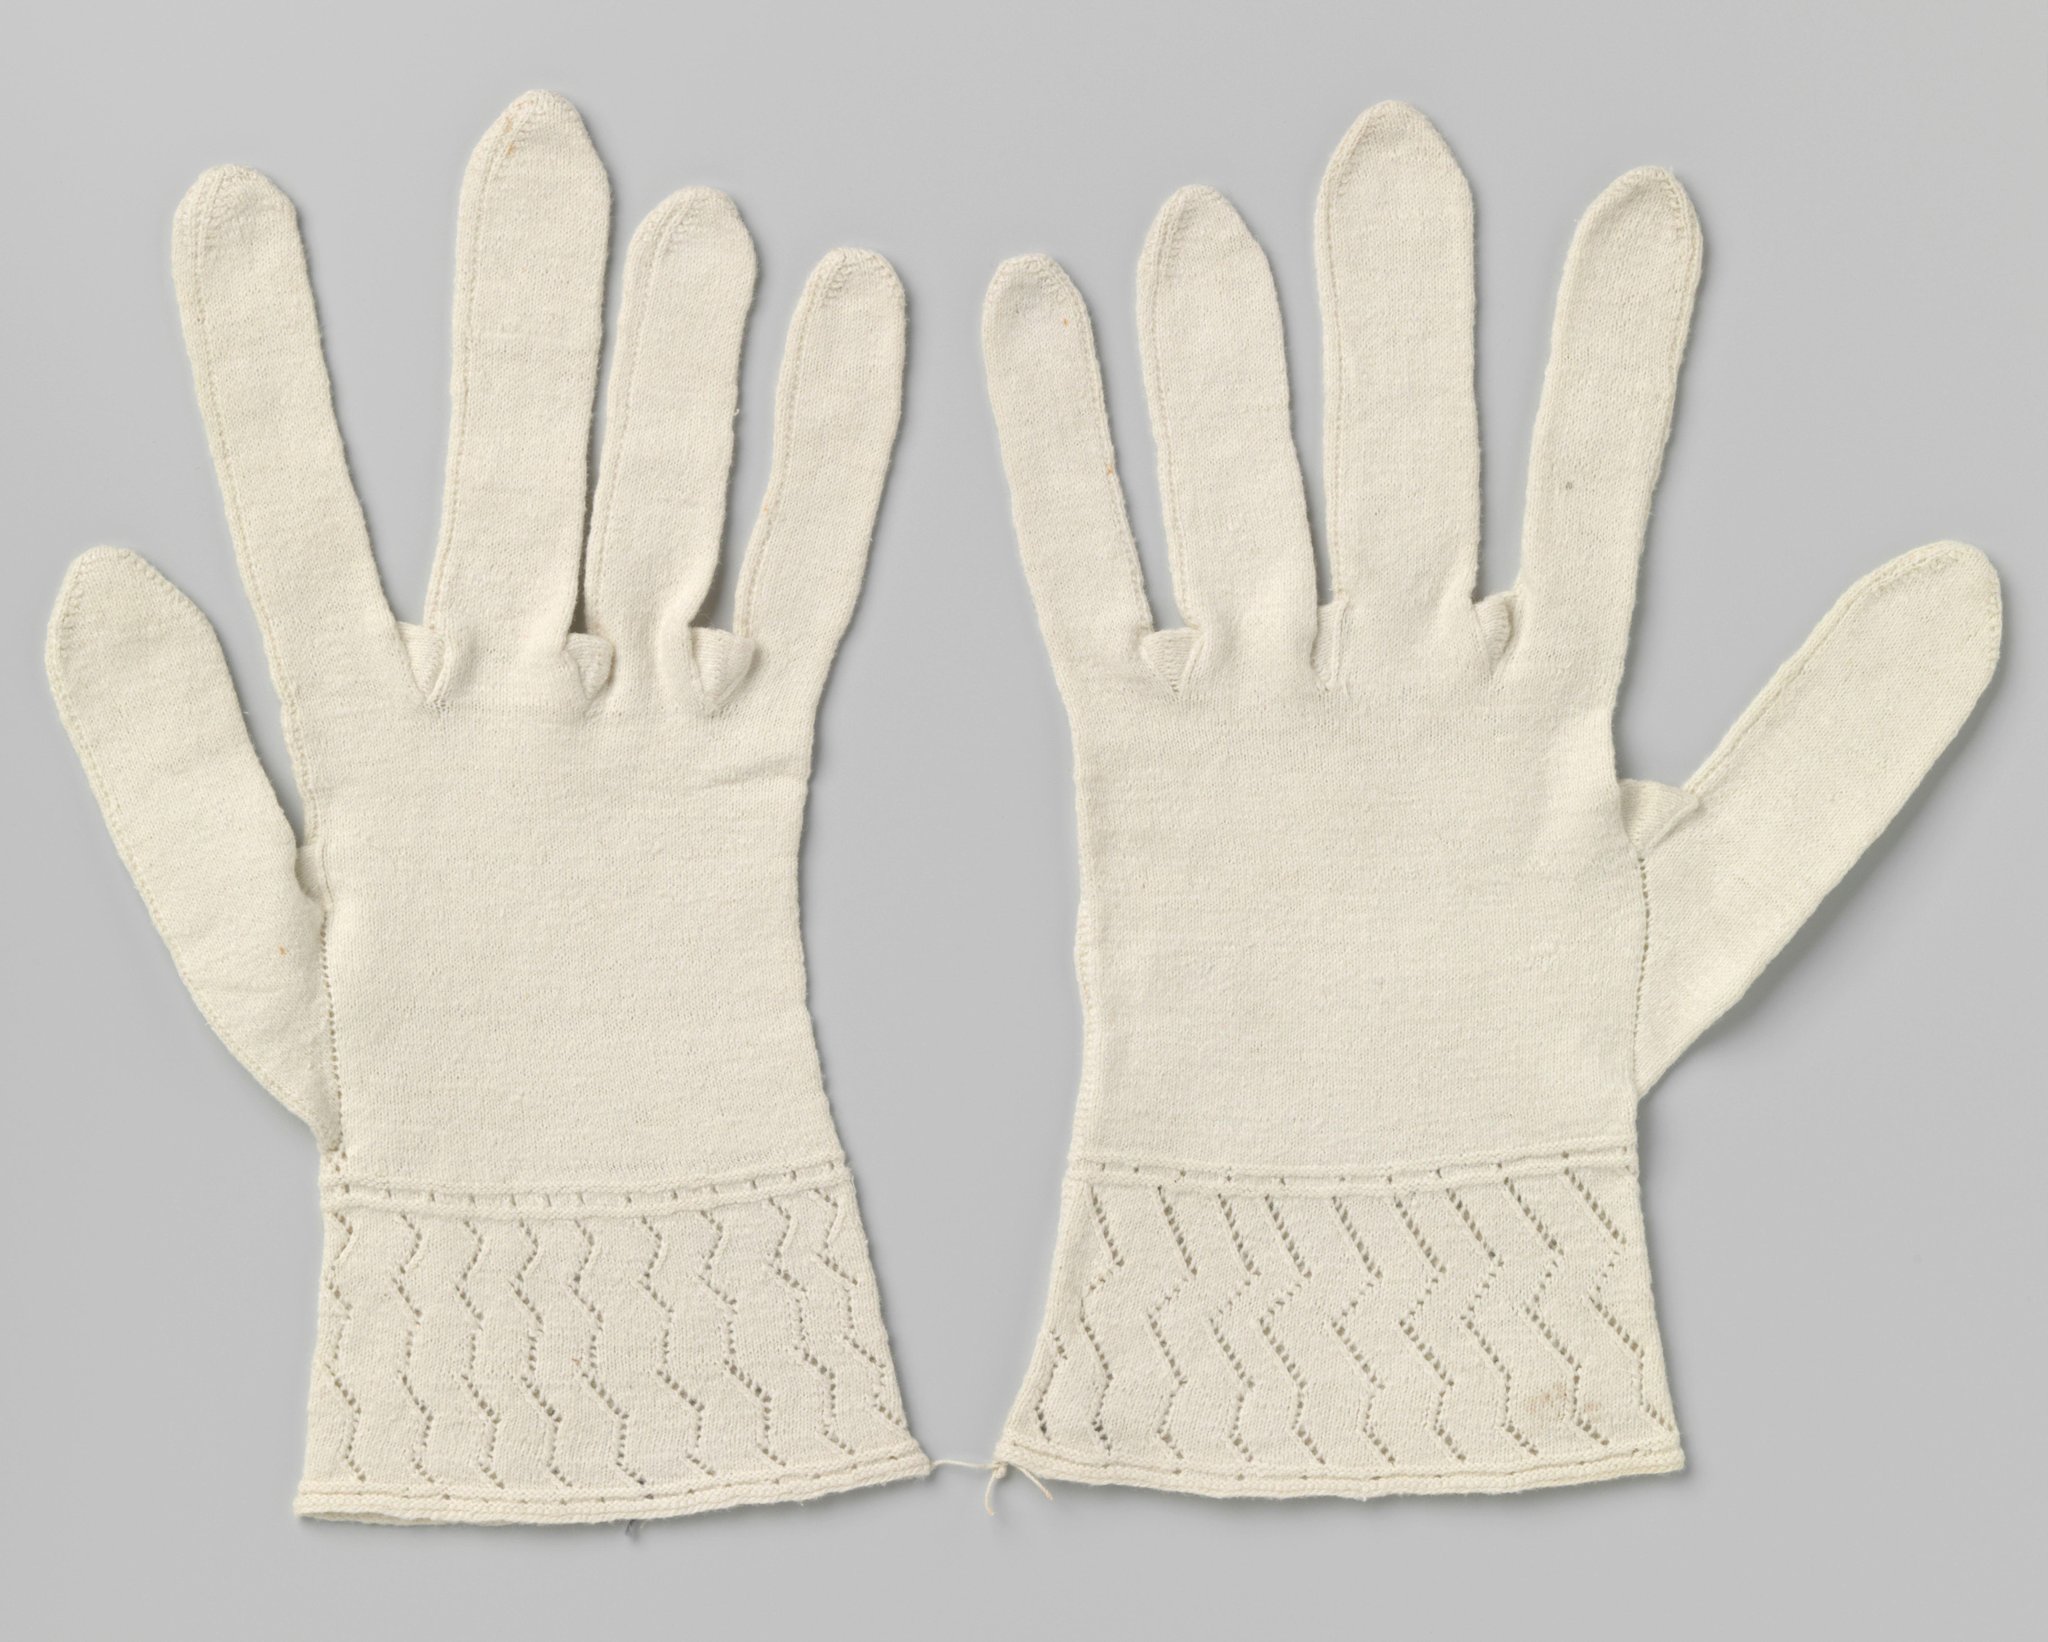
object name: menswear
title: Handschoen van witte katoen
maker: Anonymous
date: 1785-1815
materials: cotton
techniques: knitting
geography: netherlands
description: Een paar wit katoenen handschoenen. Einde der 18e en begin der 19e eeuw.